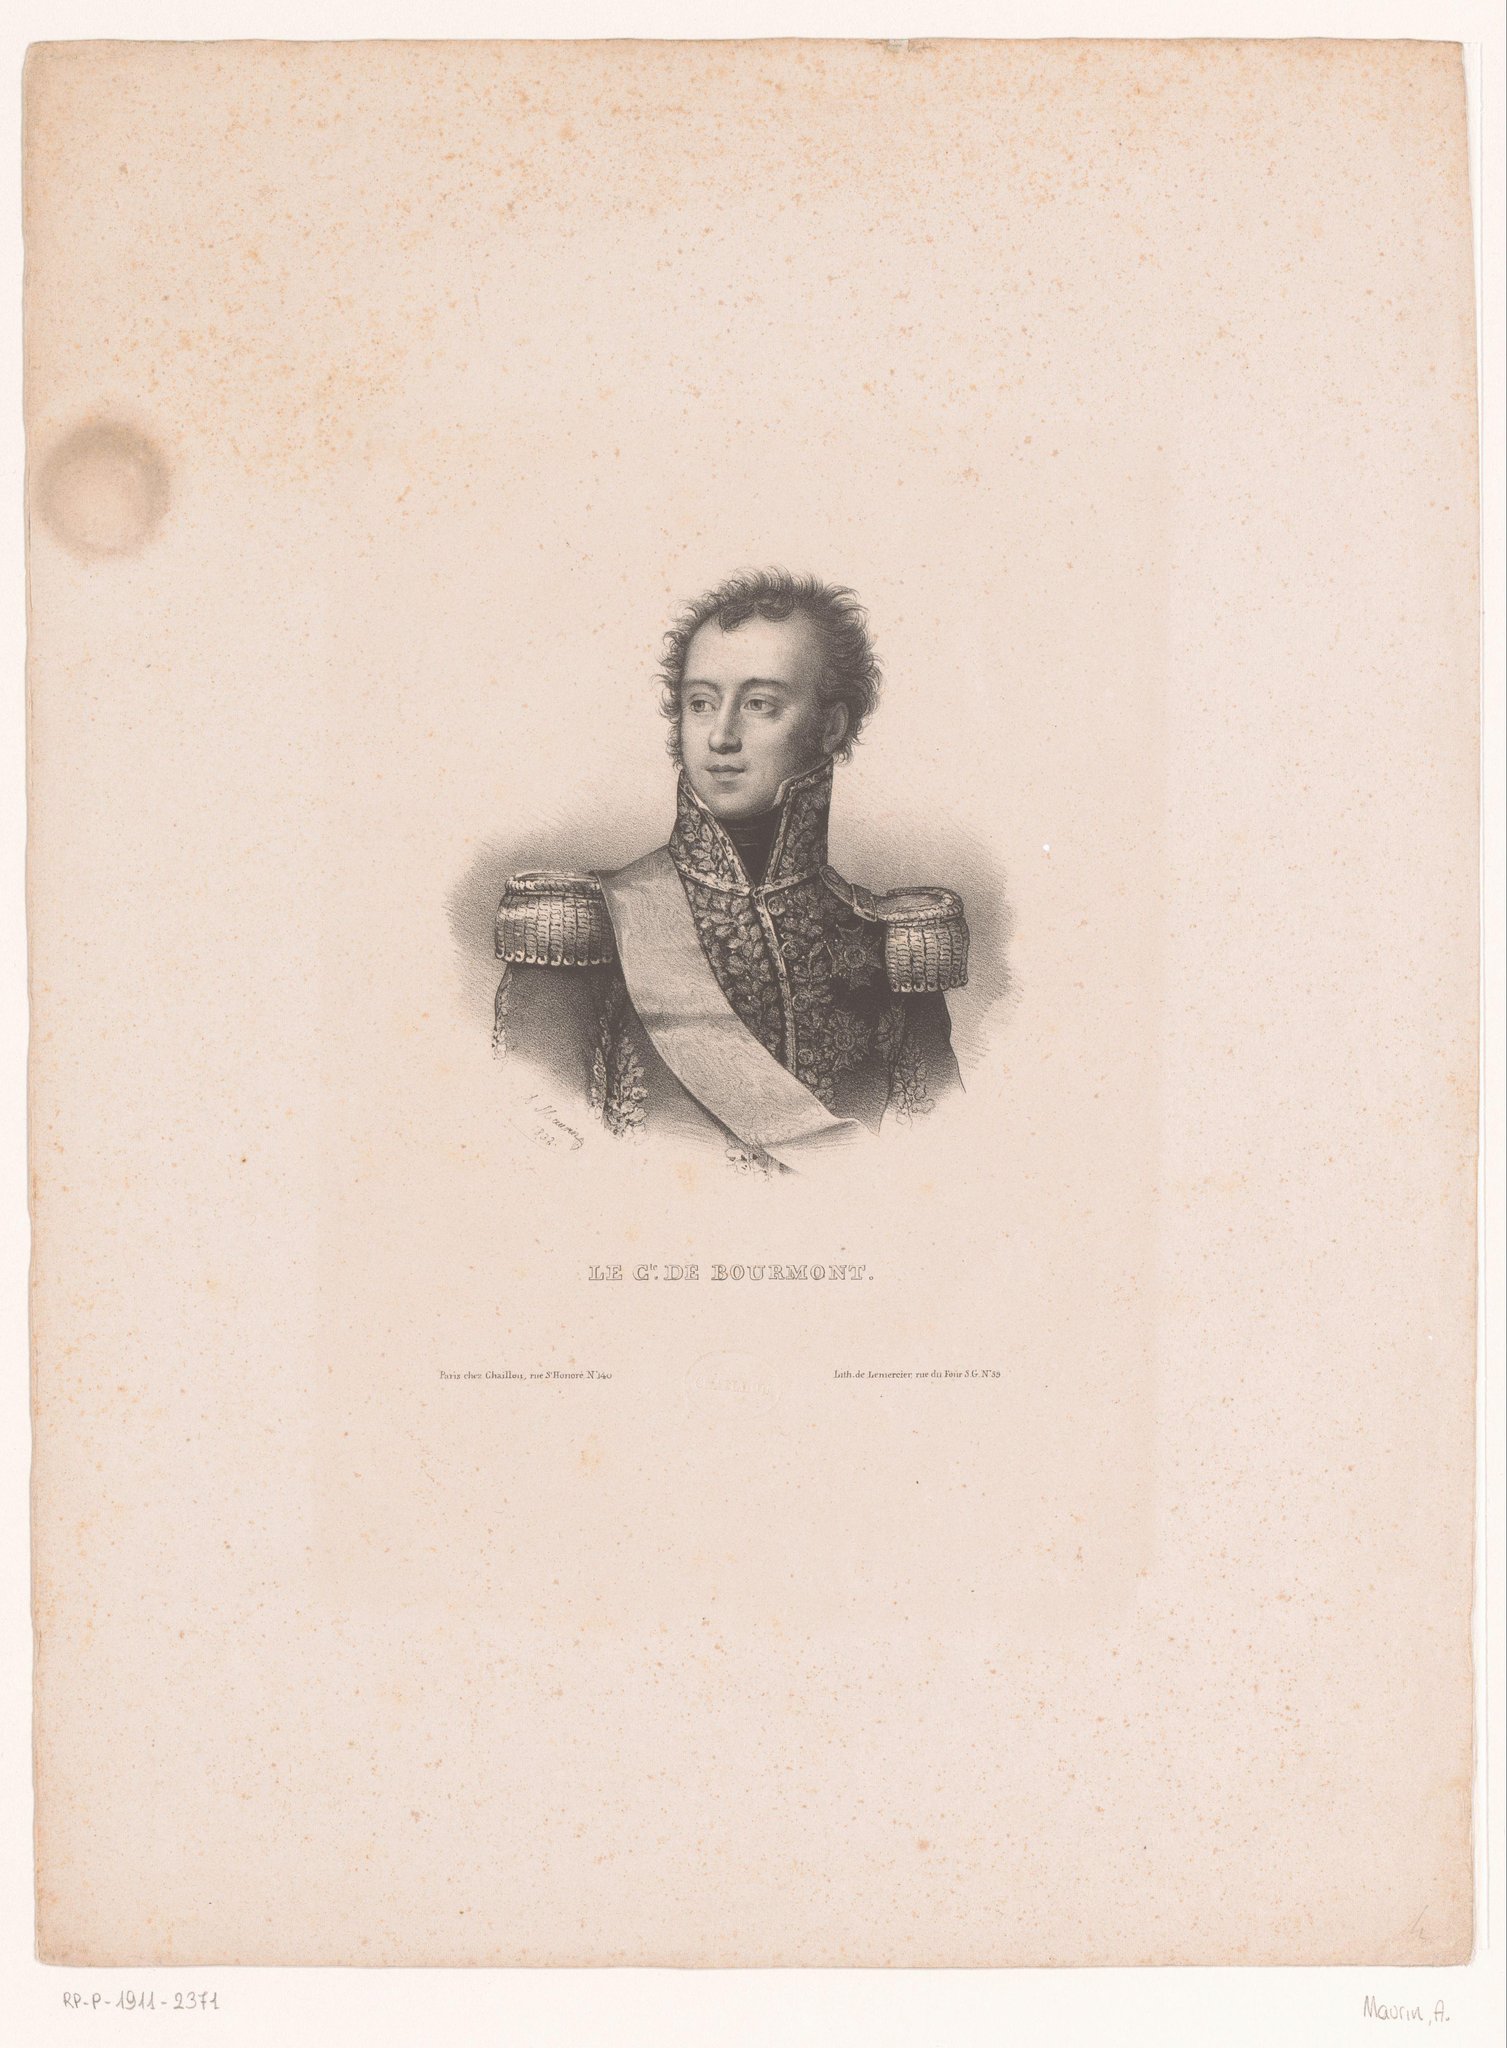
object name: print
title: Le Cte. de Bourmont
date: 1832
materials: paper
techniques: lithograph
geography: paris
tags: historical persons (portraits and scenes from the life)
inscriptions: collector's mark: Lugt 2228, check stamp: Lugt 4733